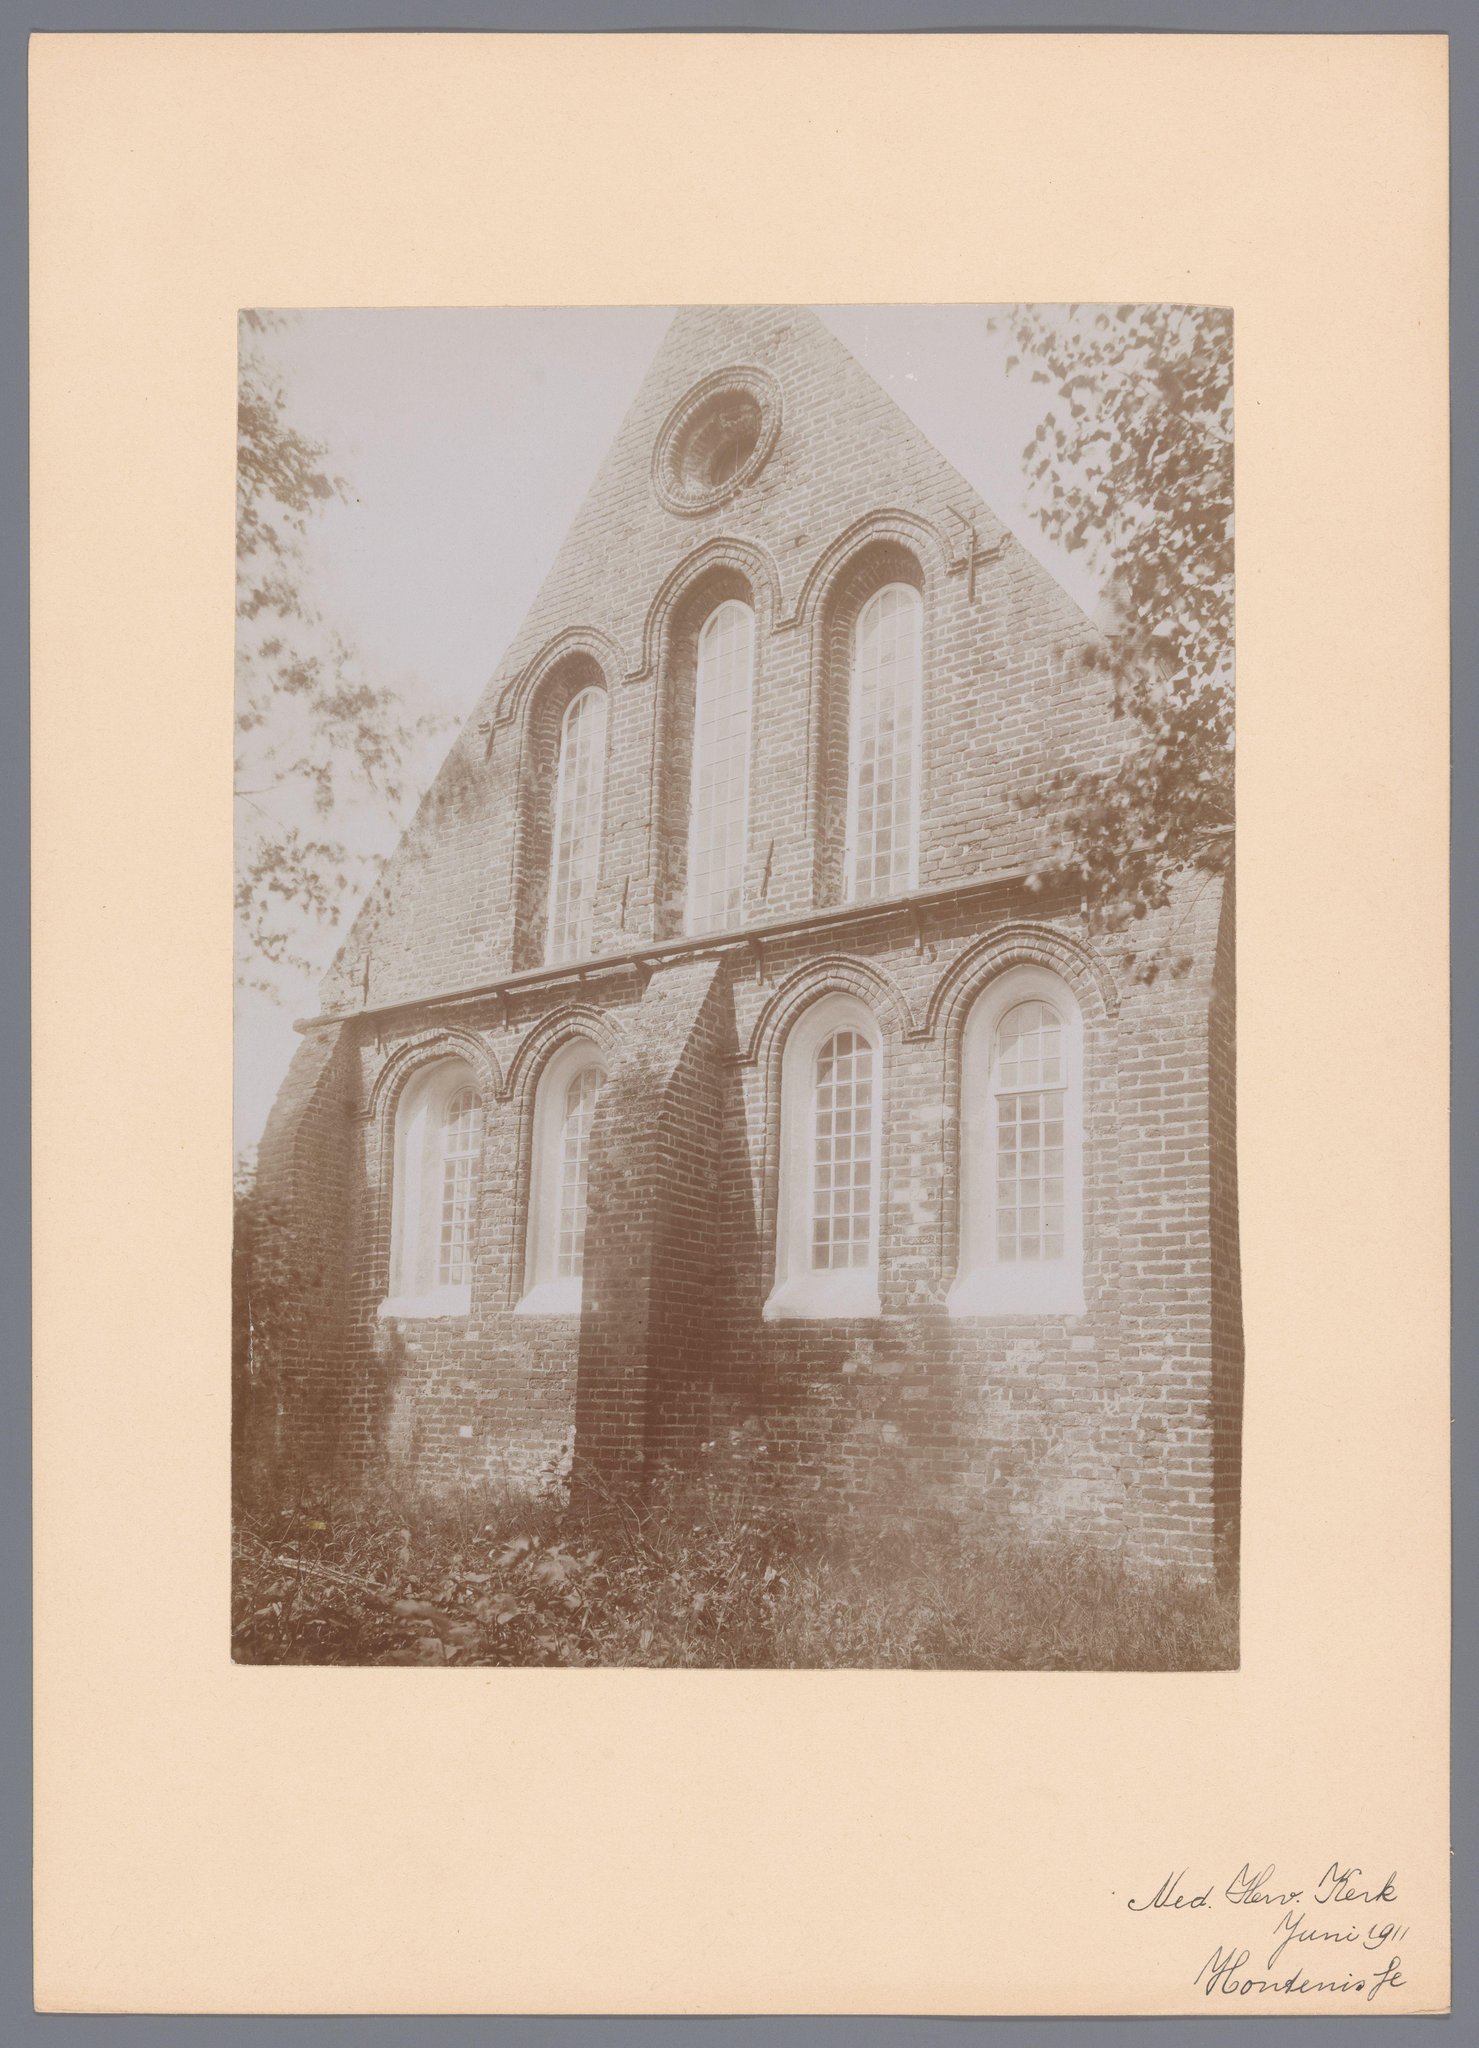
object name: photograph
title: Gevel van de Hervormde Kerk te Hulst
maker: anoniem (monumentenzorg)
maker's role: fotograaf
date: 1911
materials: cardboard, photographic support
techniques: collodion silver print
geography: hulst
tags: church (exterior)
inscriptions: annotation: ‘Ned. Herv. Kerk/ Juni 1911/ Hontenisse’